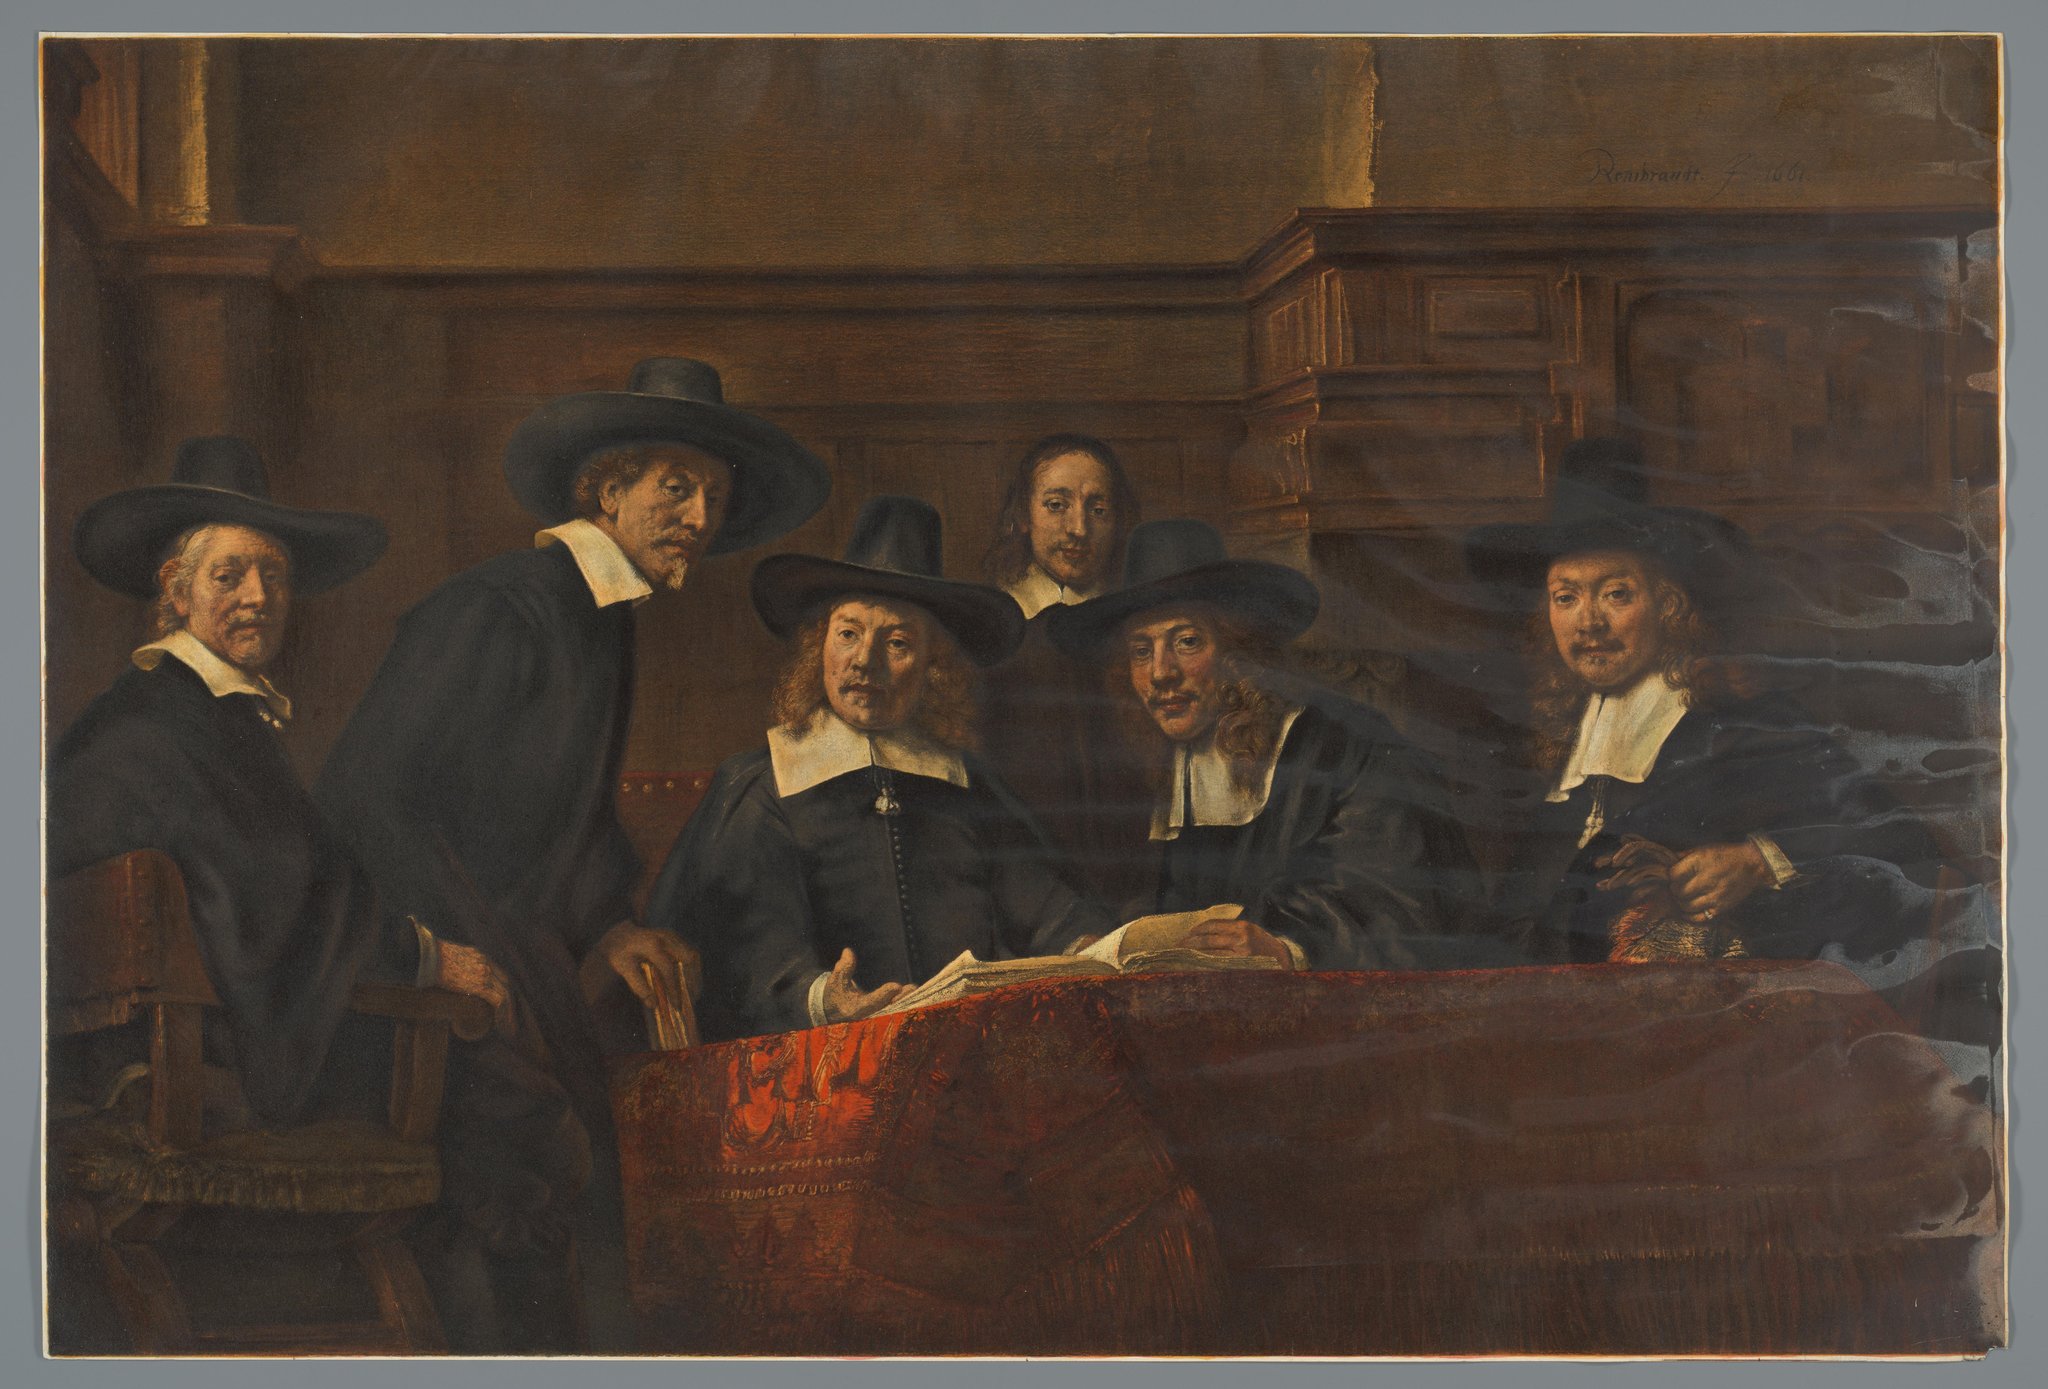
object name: photomechanical print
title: Reproductie van het schilderij de Staalmeesters door Rembrandt van Rijn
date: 1875-1911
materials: cardboard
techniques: collotype process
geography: munich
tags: board of a guild, painting, drawing and the graphic arts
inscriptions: collector's mark